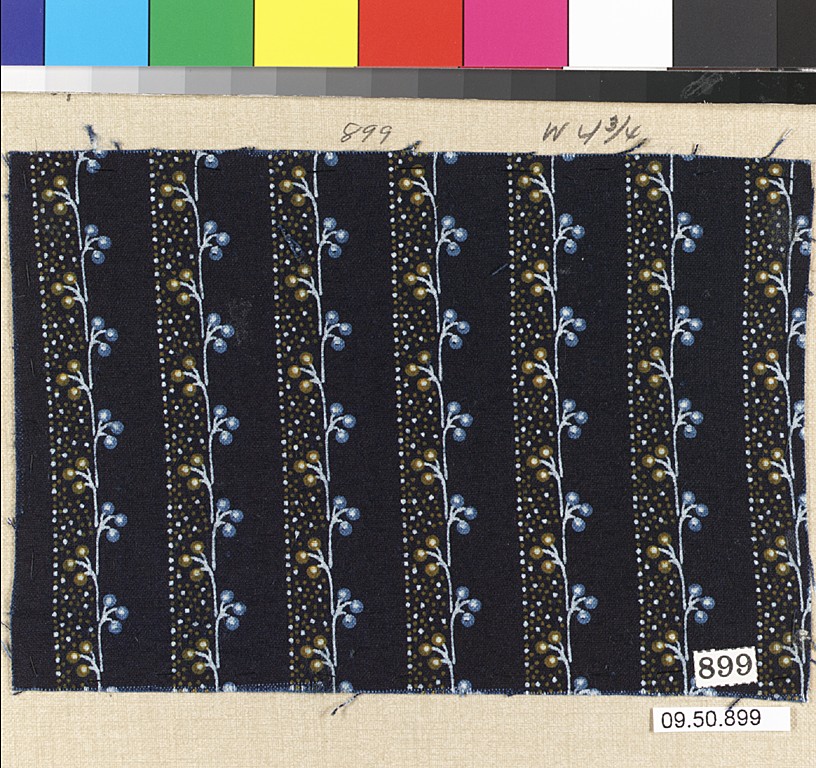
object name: piece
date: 1801-1900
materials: cotton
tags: leaves